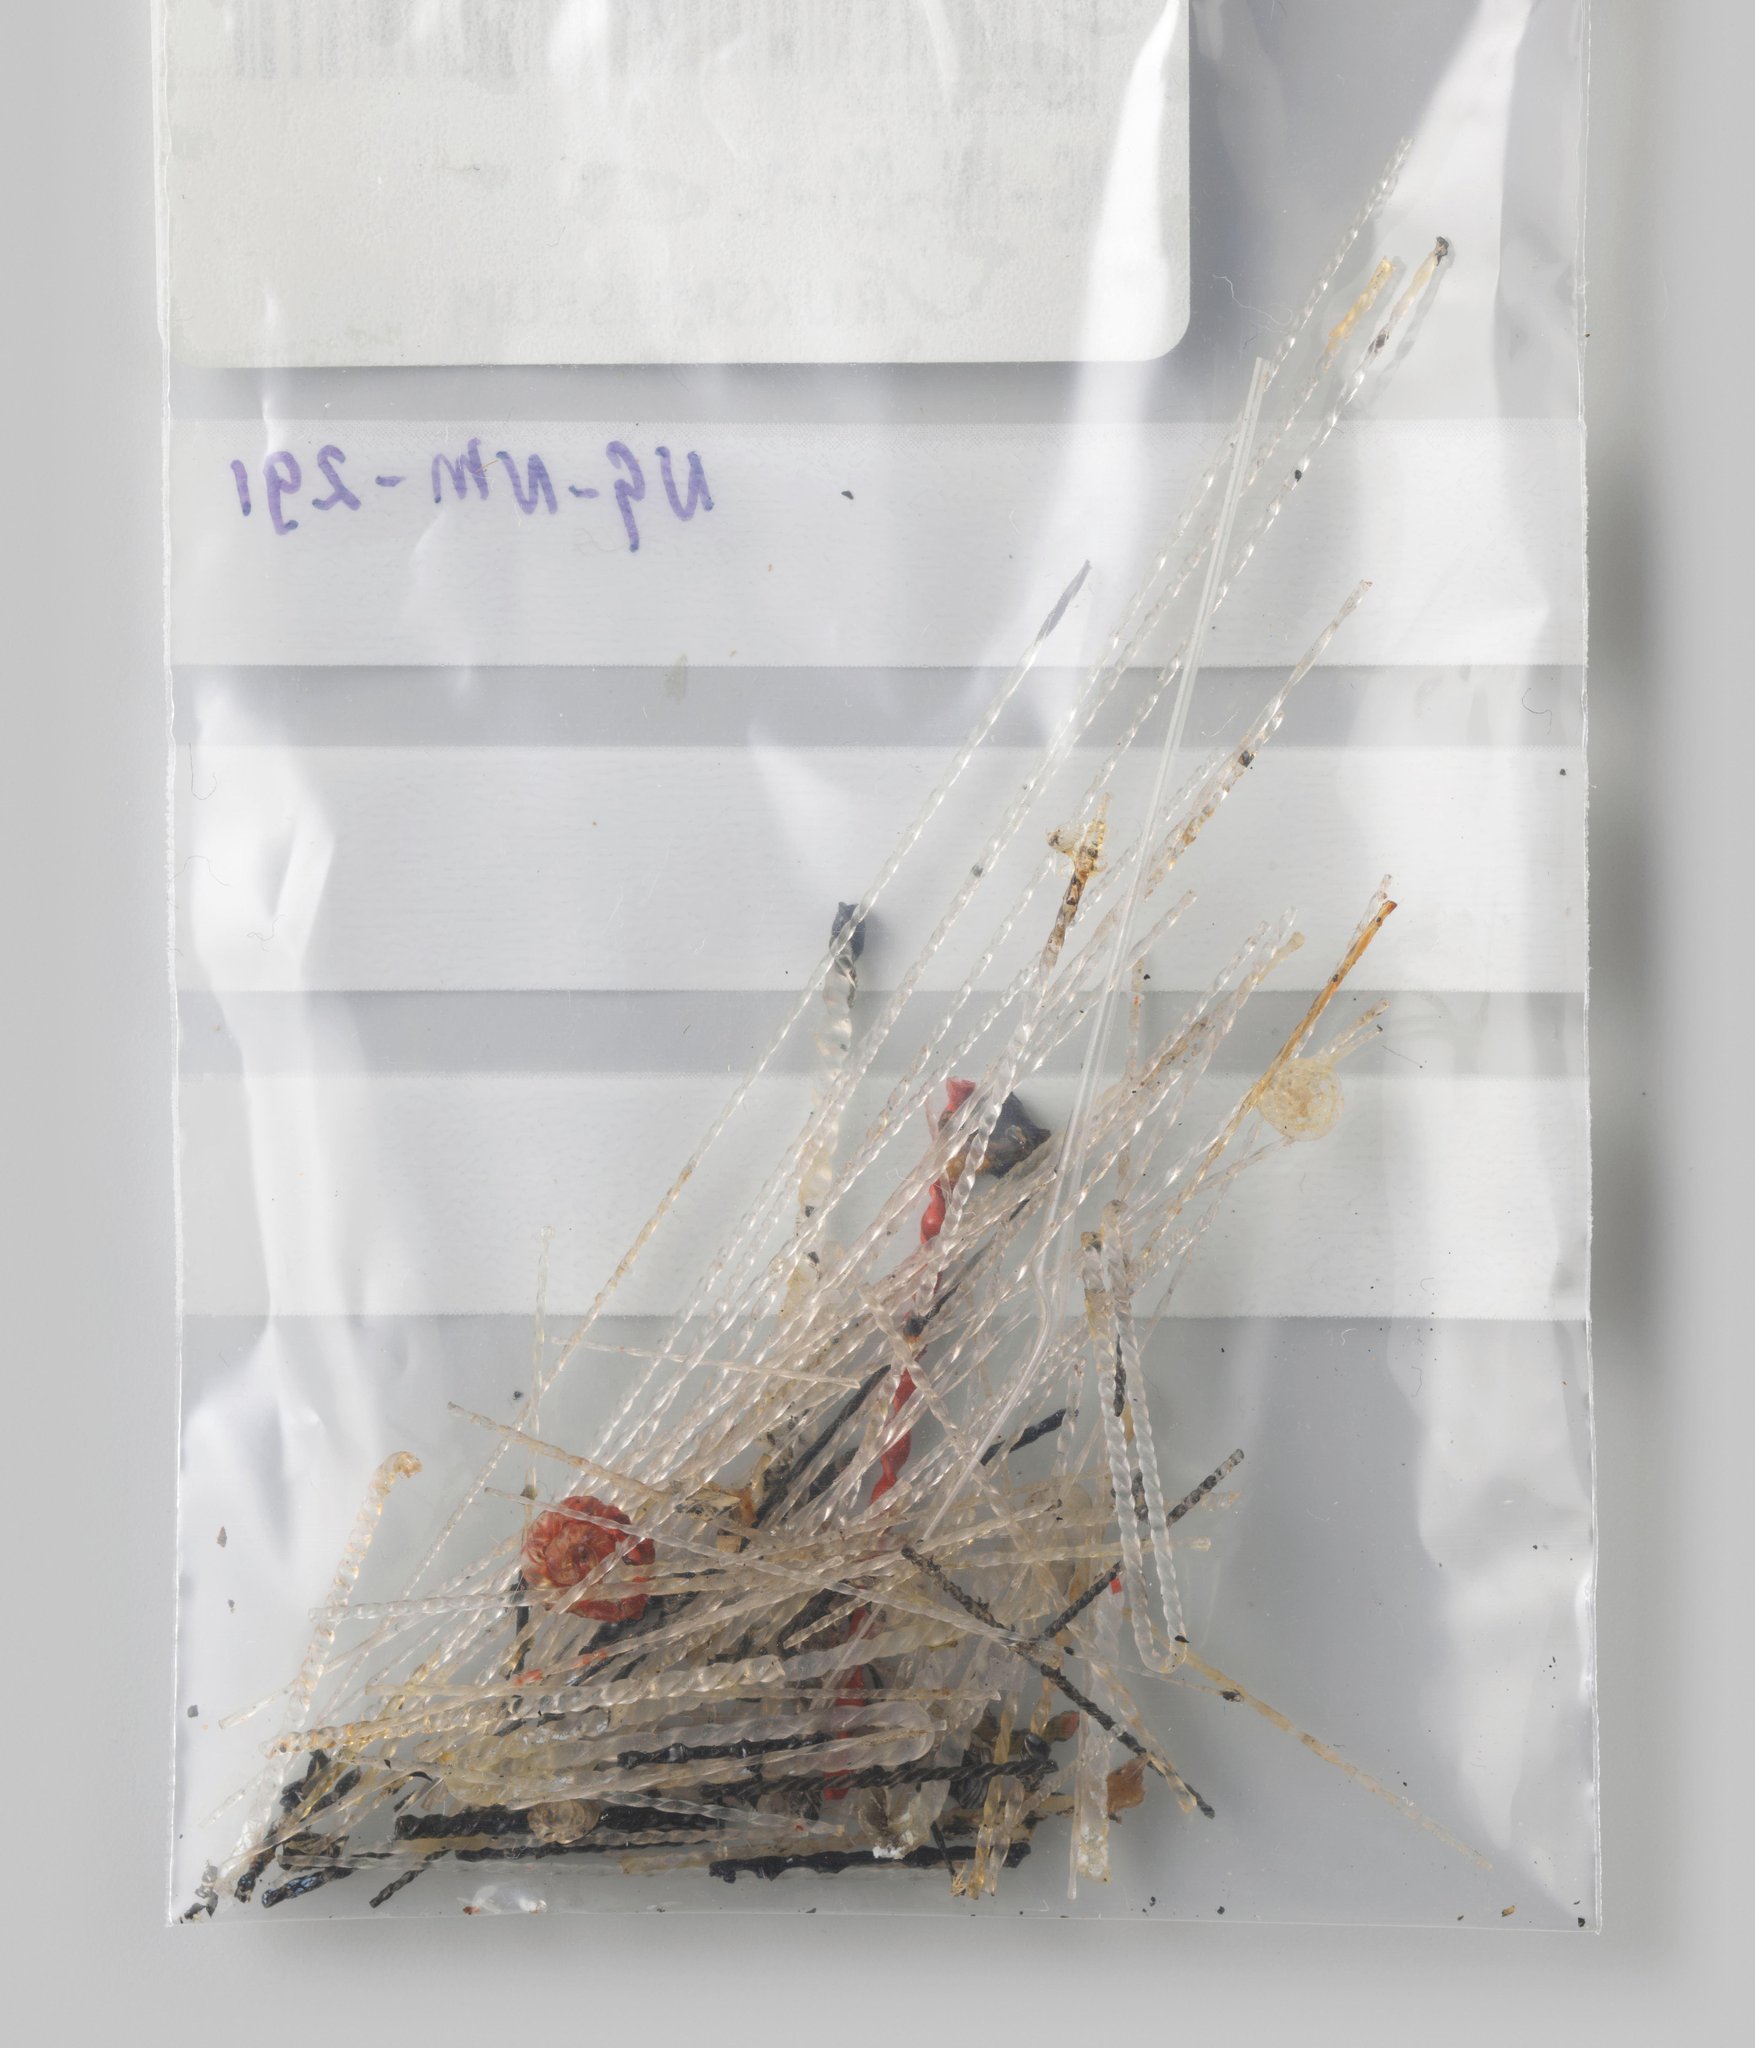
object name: ship model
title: Fragments of a Glass Model of a 76-Gun Ship of the Line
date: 1770-1820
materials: glass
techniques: glassblowing